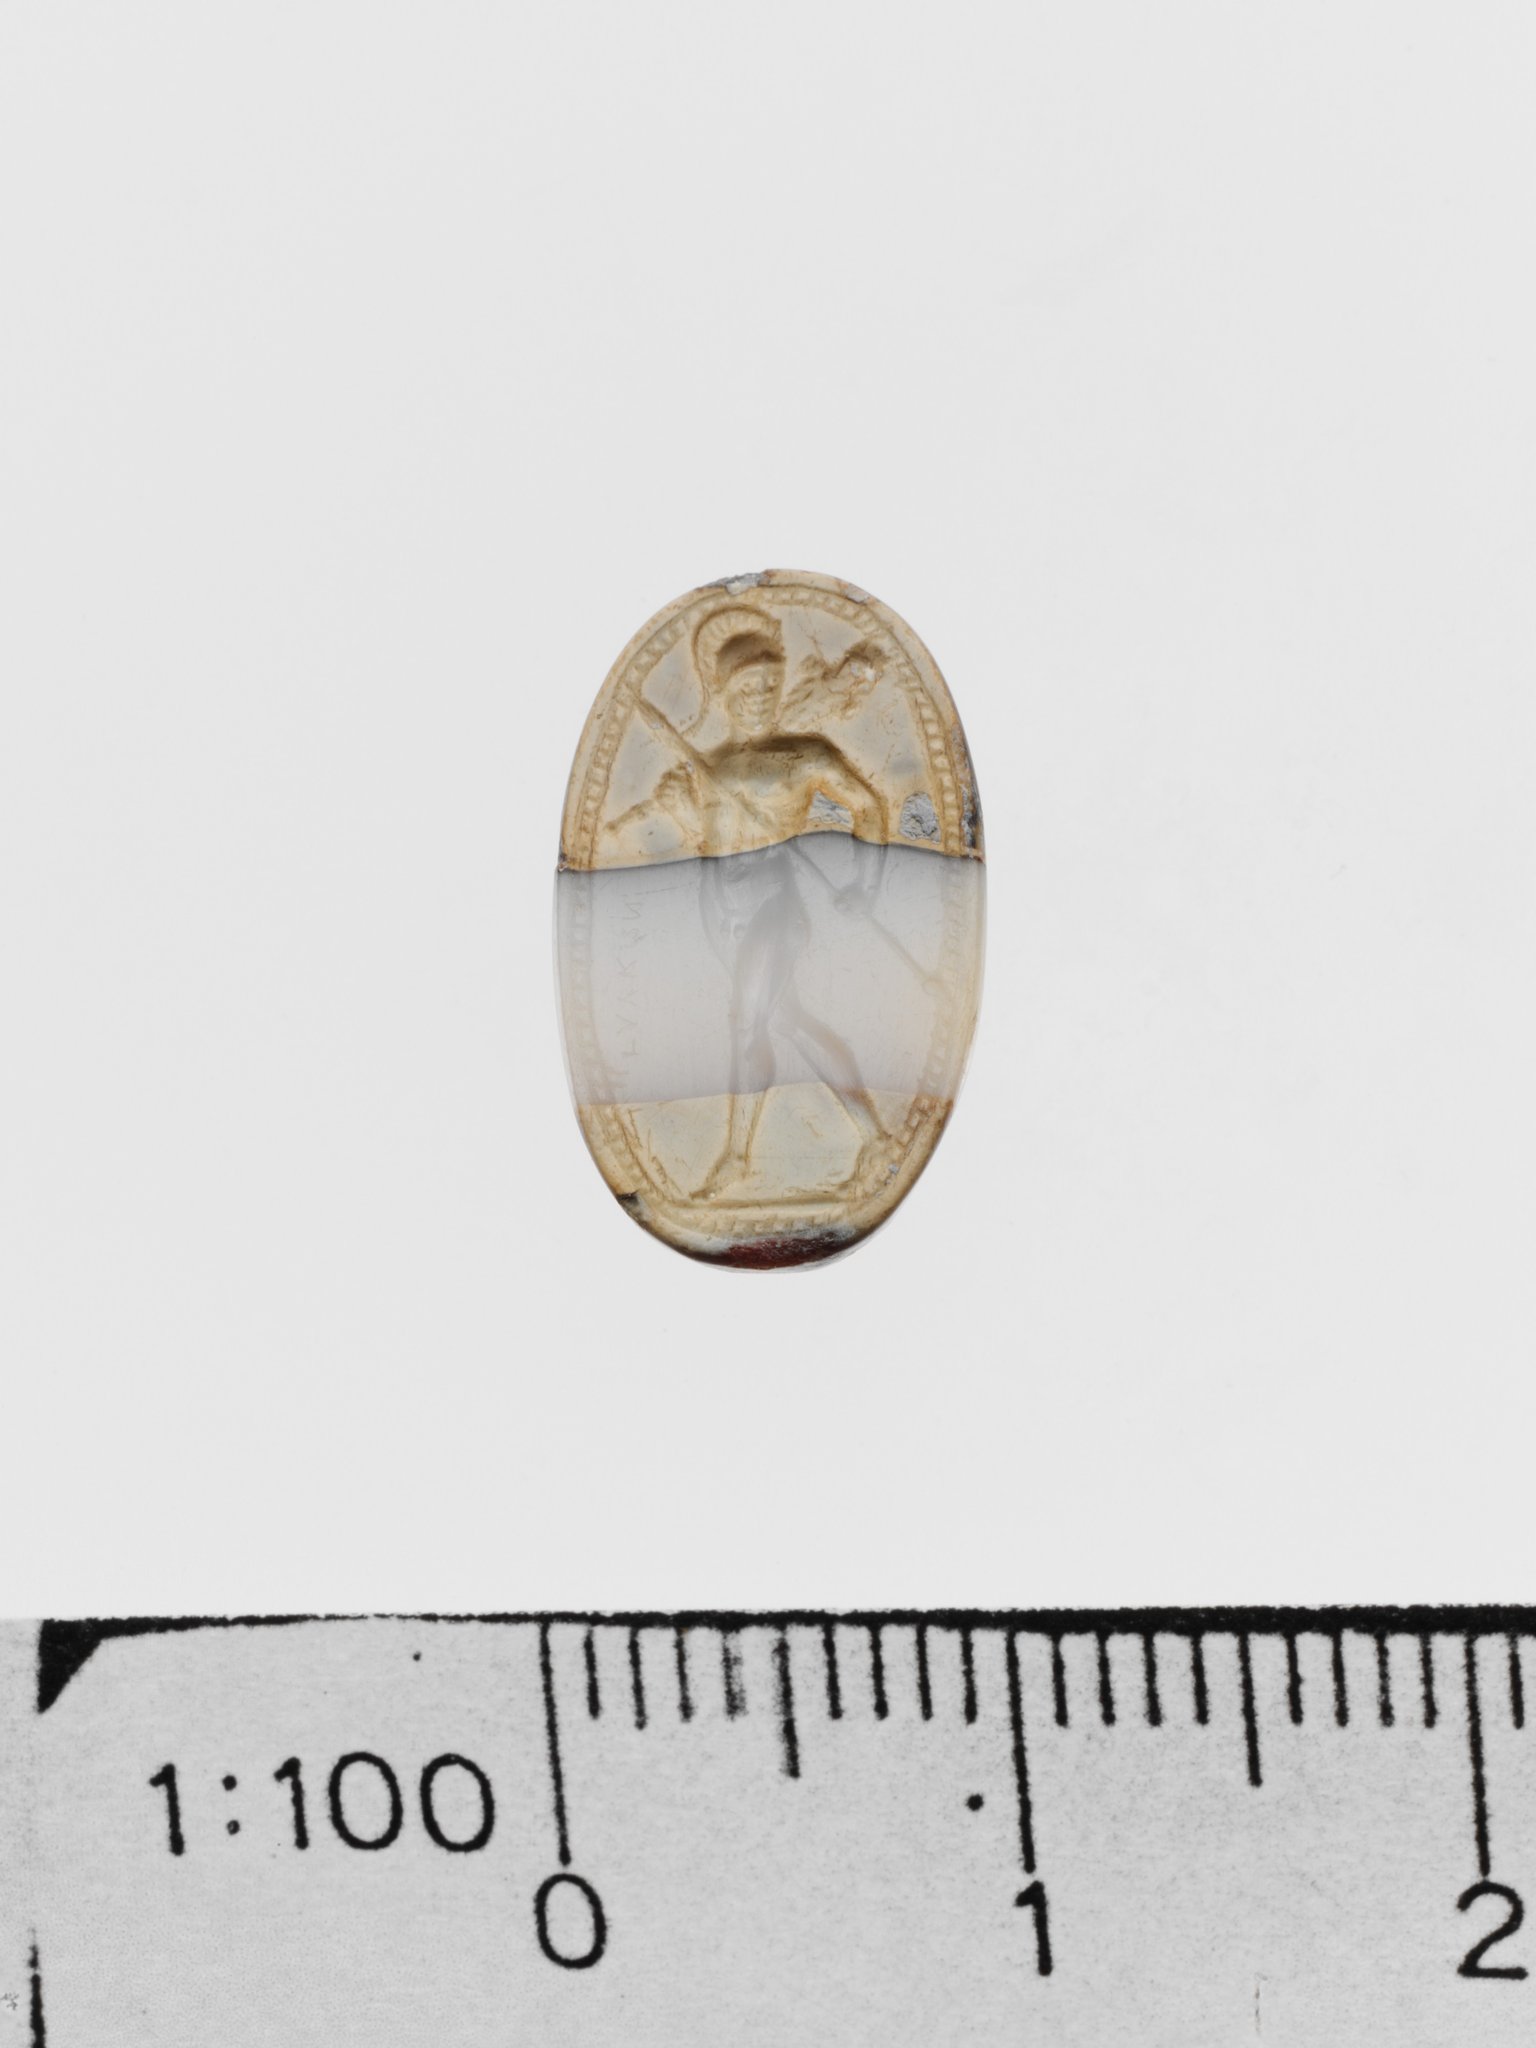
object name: intaglio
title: Banded agate ring stone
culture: roman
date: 1-100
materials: stone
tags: soldiers,spears,male nudes